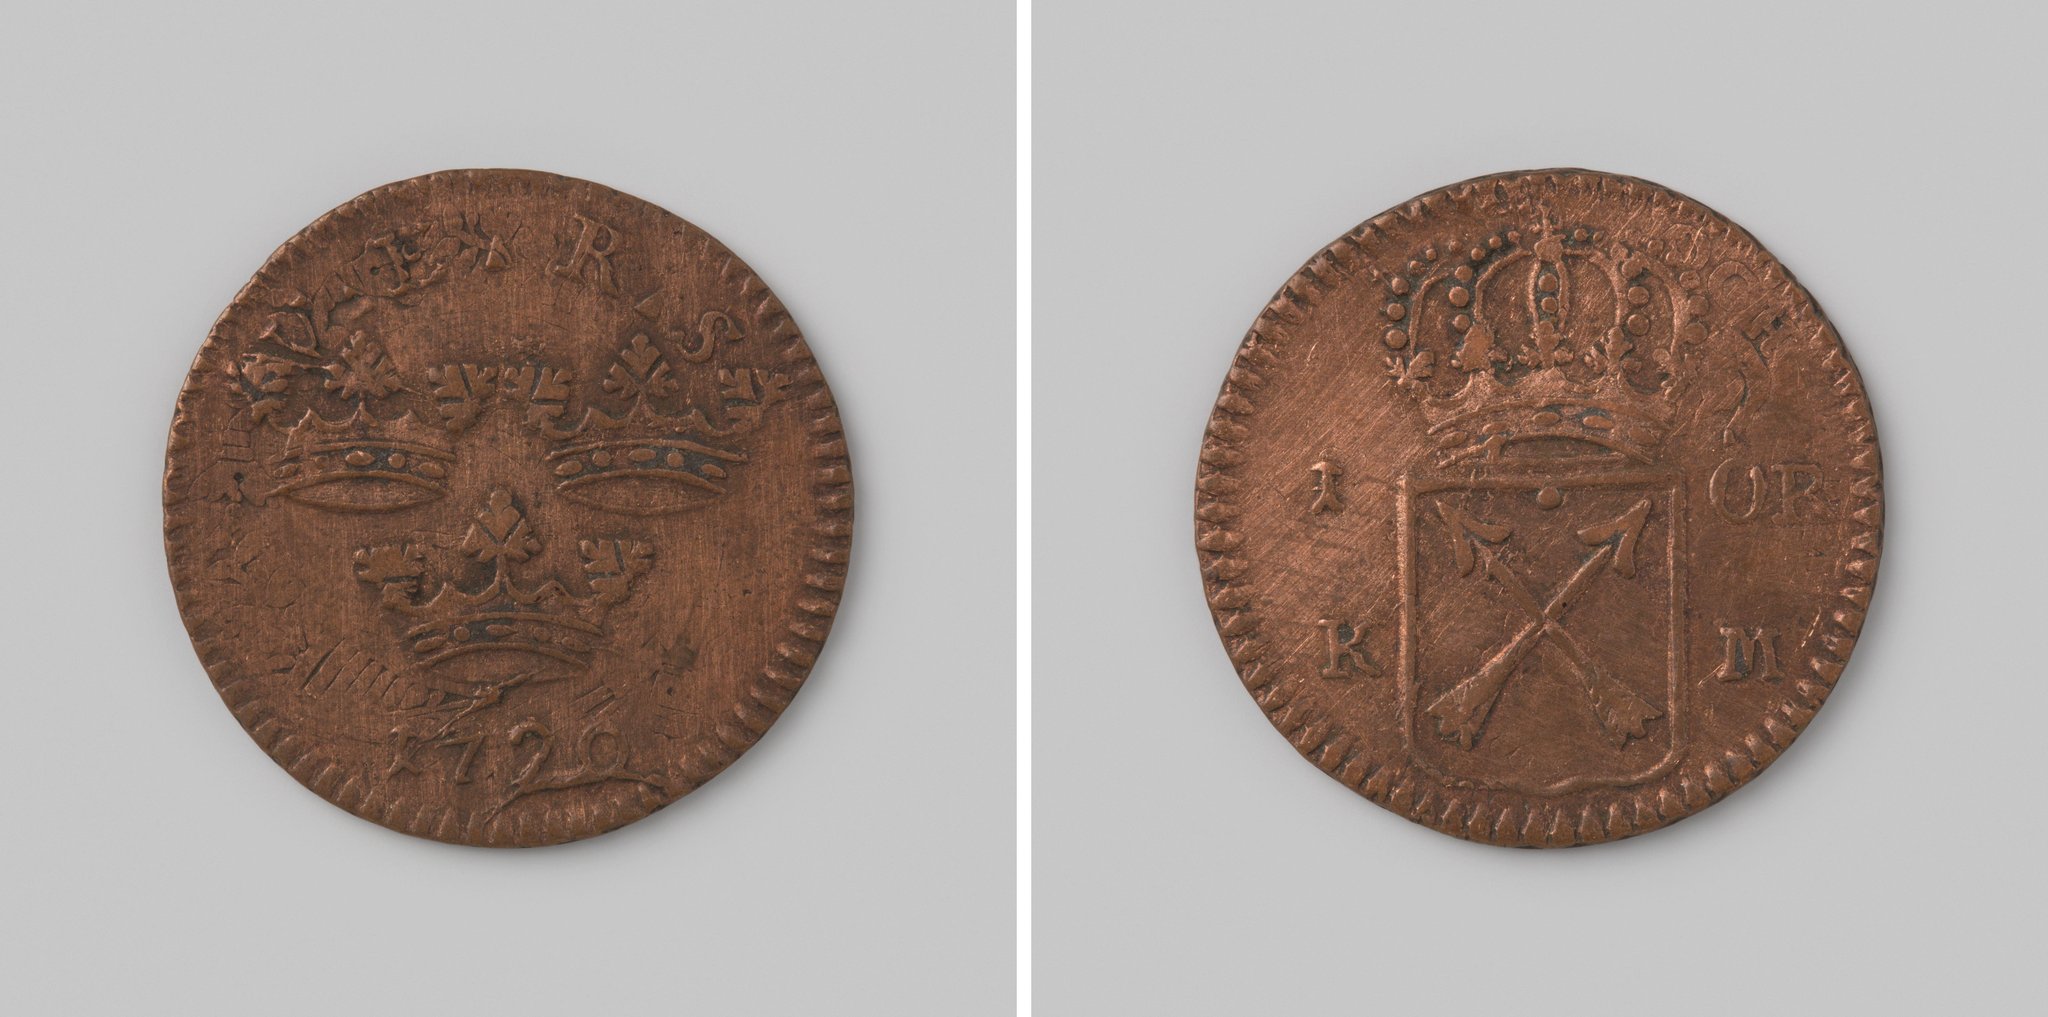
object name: coin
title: öre Koppar Mynt uit Zweden van Ulrika Eleonora,1720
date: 1720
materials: copper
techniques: striking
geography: slot rörstrand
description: Koperen munt. Voorzijde: tussen drie kronen letters V,,E,R en S. Daaronder jaartal. Keerzijde: tussen waarde-aanduiding gekroond wapenschild. Kabelrand. Op muntplaatje van nooddaler 1715-1718 geslagen.